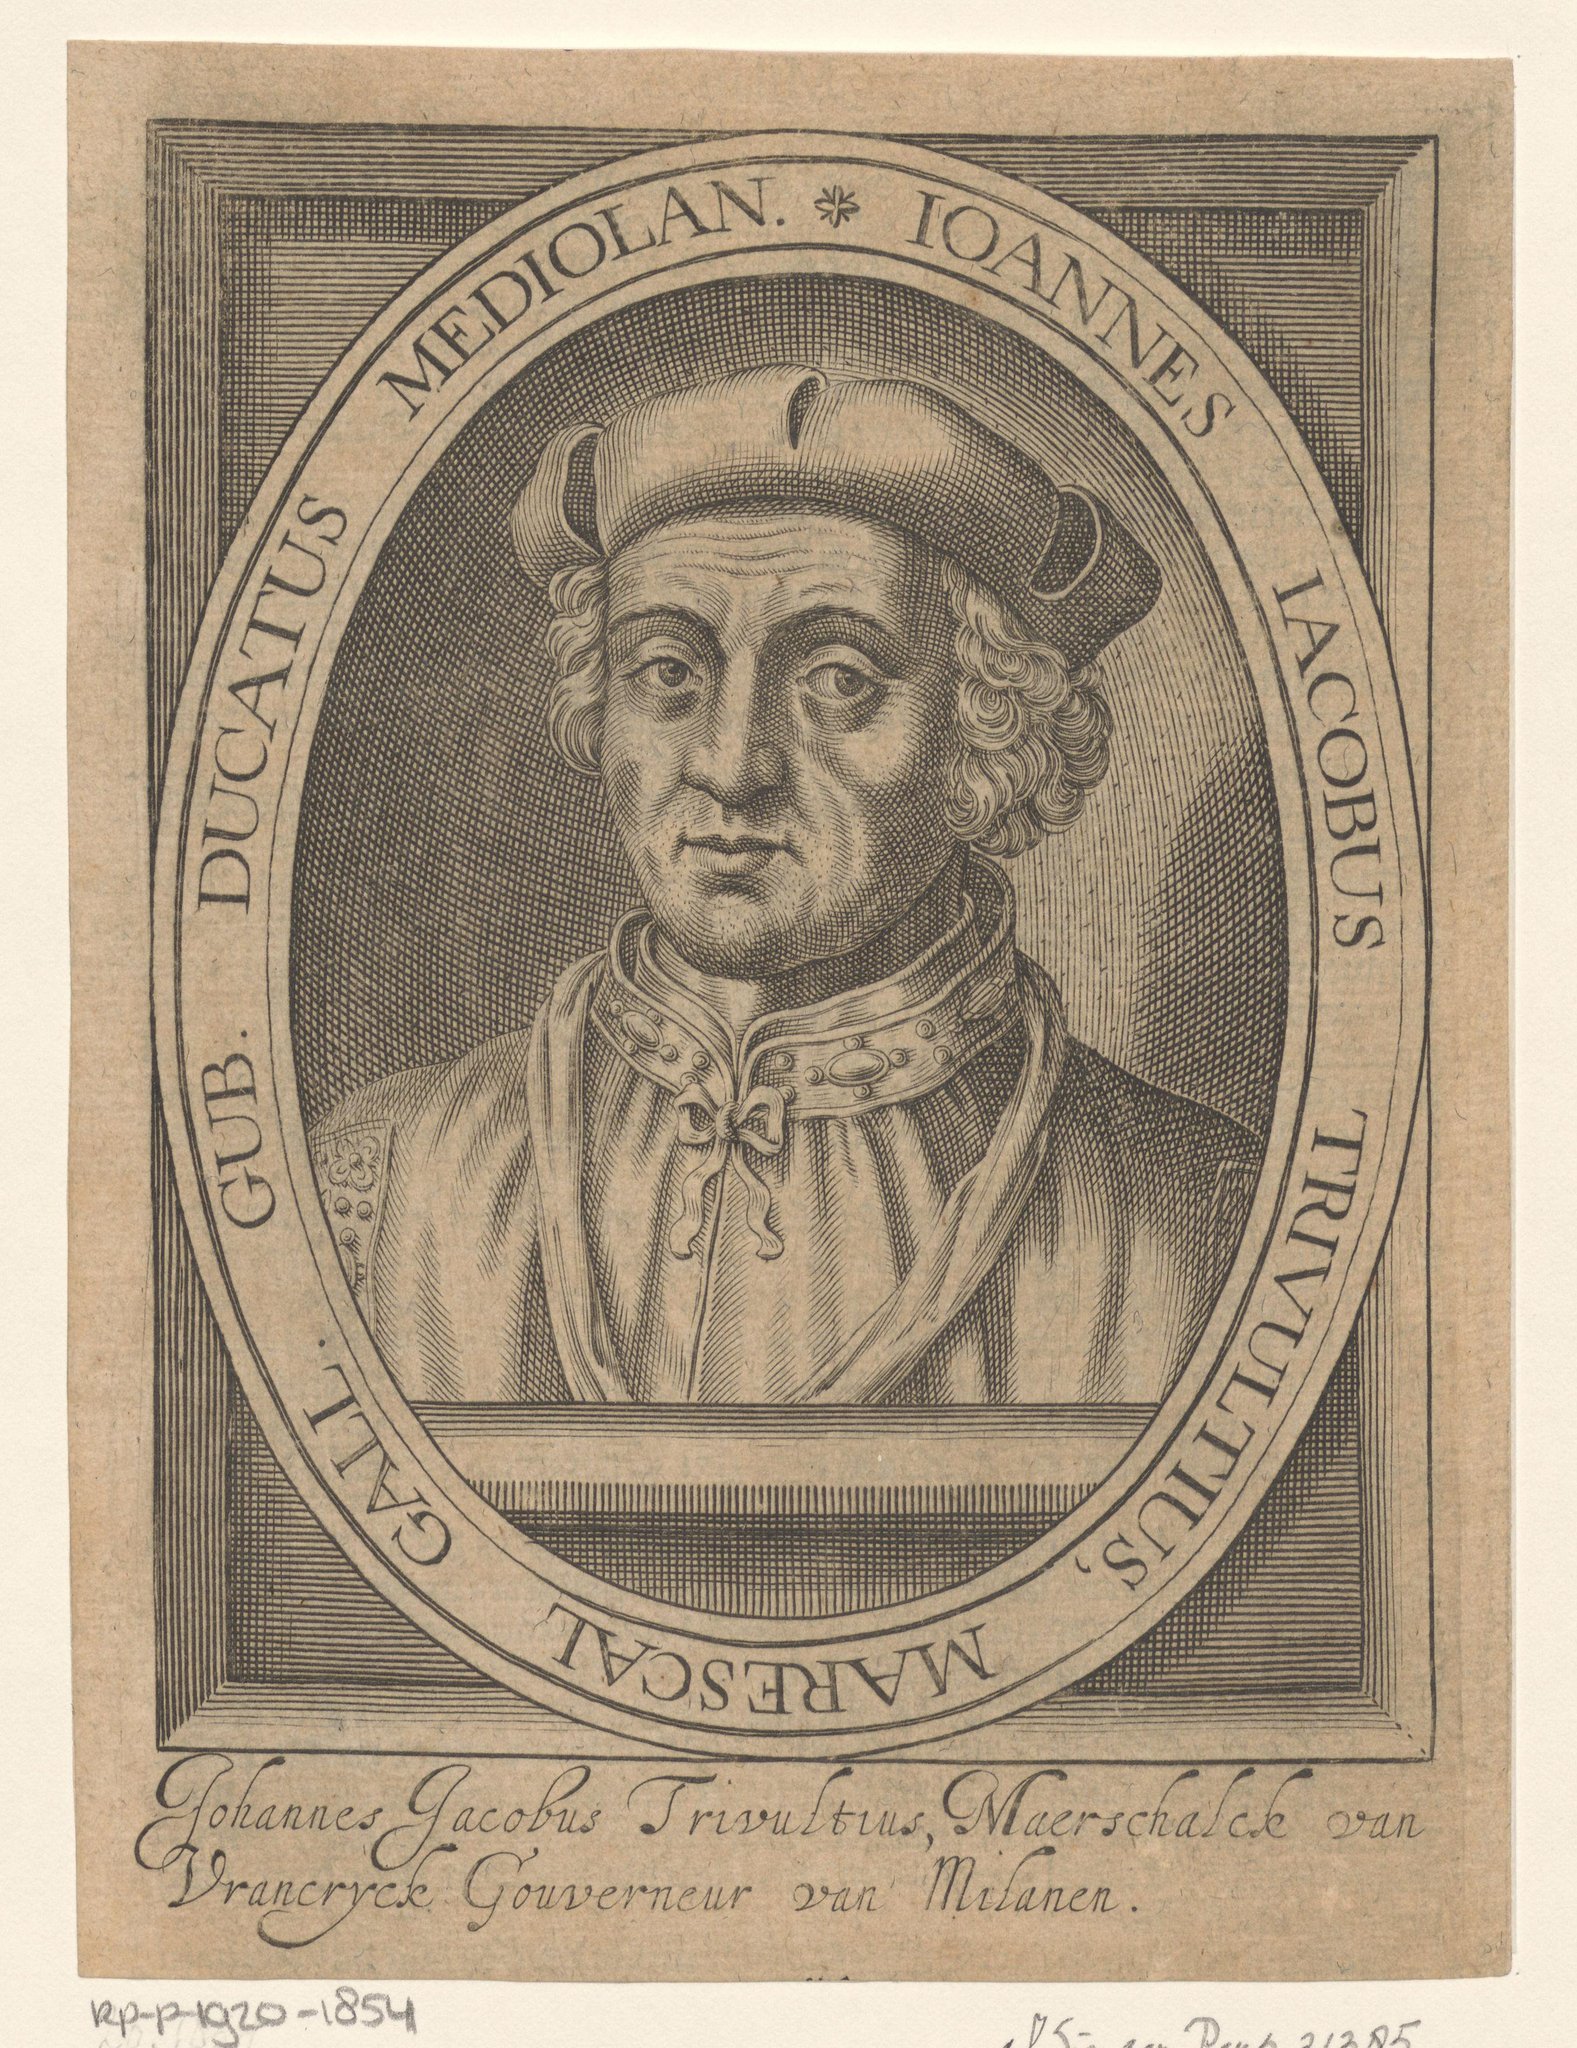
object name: print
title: Portret van Gian Giacomo Trivulzio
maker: Anonymous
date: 1617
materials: paper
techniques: engraving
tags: commander-in-chief, general, marshal, historical persons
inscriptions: collector's mark: Lugt 2228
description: Prent waarschijnlijk uit: Clerck, Nicolaes de. Tooneel der beroemder hertogen, princen, graven ende krygs-helden (...). Delft: Nicolaes de Clerck, 1617.